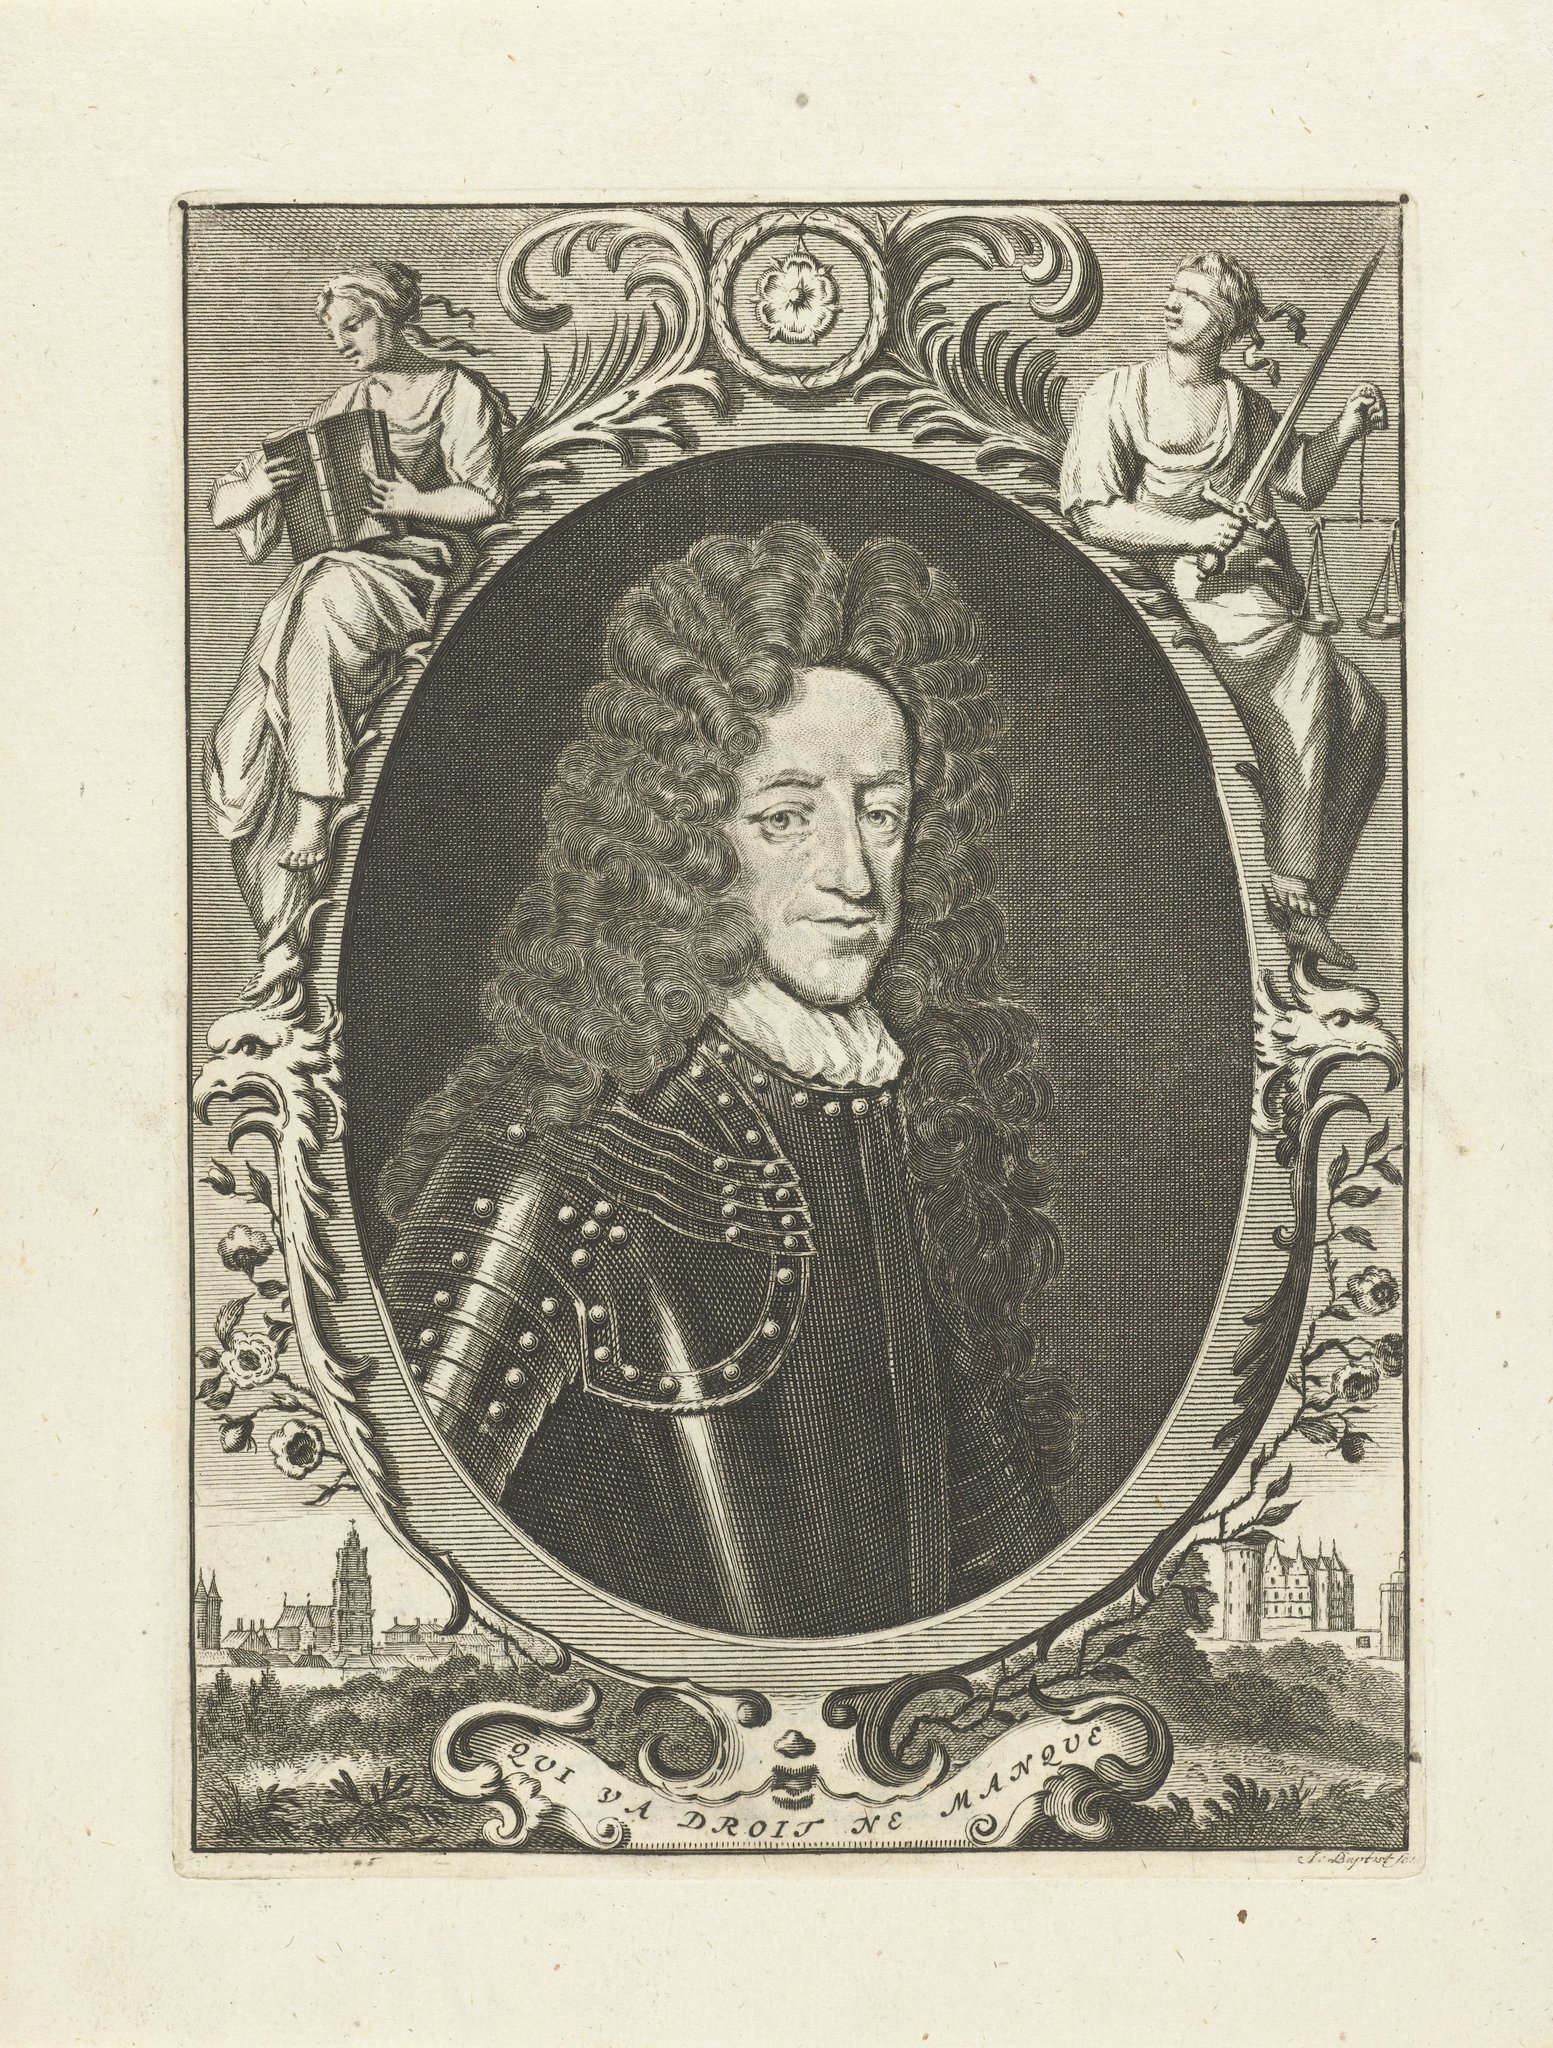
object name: print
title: Portret van Jan van Arnhem, heer van Rosendael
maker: jacobus baptist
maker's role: print maker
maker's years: 1658-1704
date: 1693-1704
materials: paper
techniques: engraving, etching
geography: amsterdam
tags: jan van arnhem, justice, 'justitia'; 'giustitia divina' (ripa) ~ one of the four cardinal virtues, historical persons, armorial bearing, heraldry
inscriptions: collector's mark: Lugt 2228, inscription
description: Portret van Jan van Arnhem, heer van Rosendael in een harnas. Aan weerszijden van het portret Jusitita en een vrouw die een boek leest. Onder het portret een motto: Qui va droit ne manque. Rechts van het motto een gezicht op het kasteel Rosendael, en links een gezicht op Arnhem.